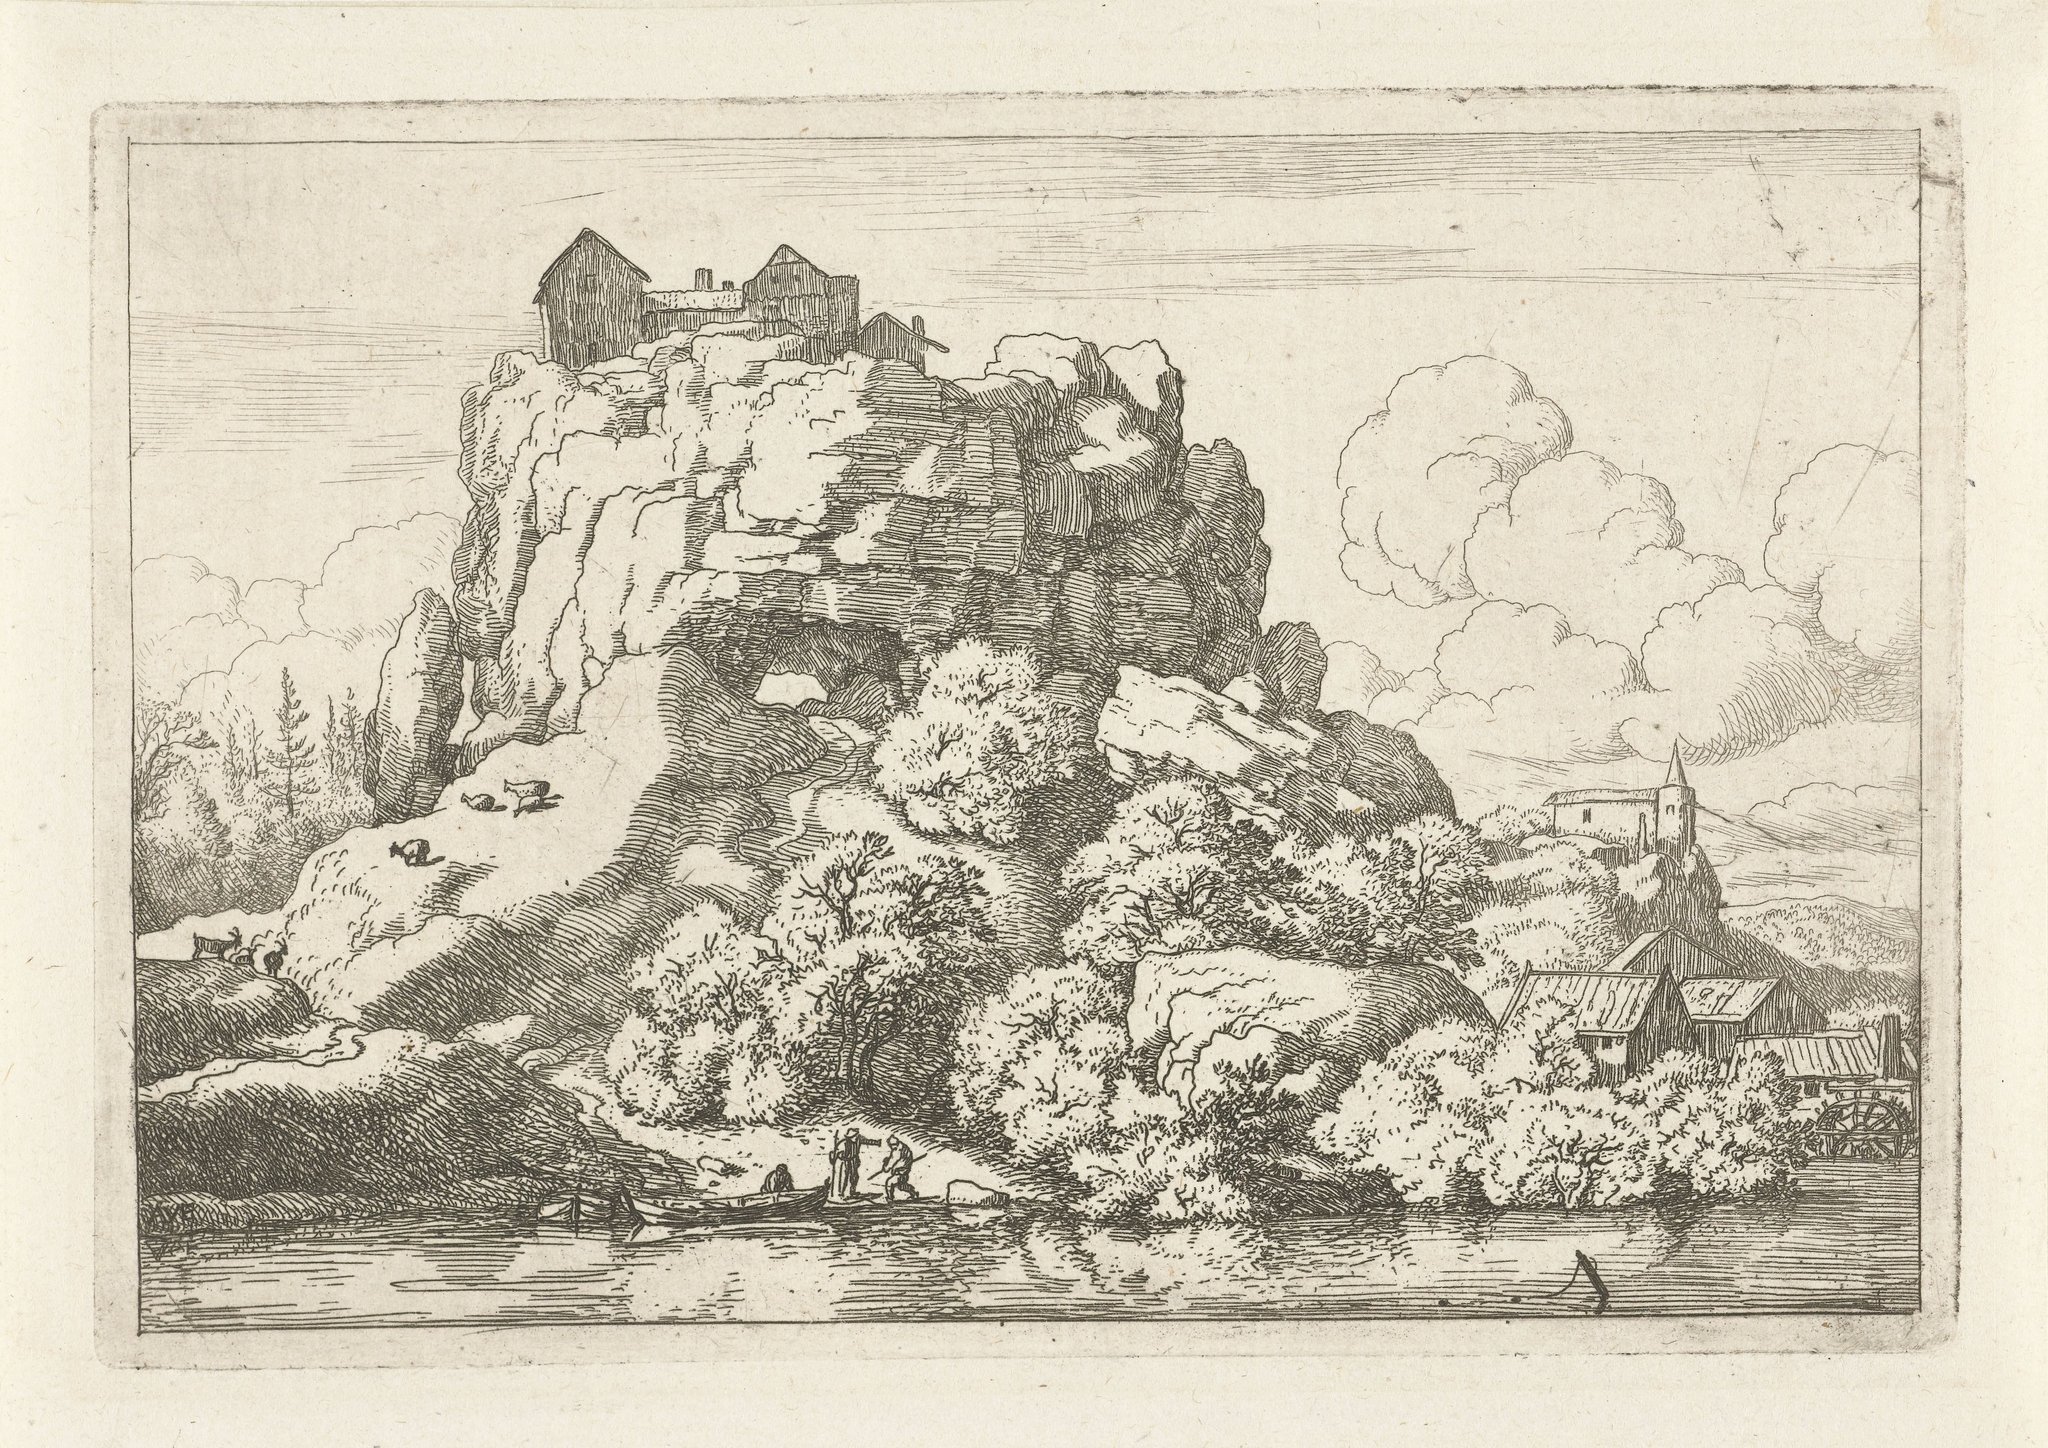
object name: print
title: Landschap met rivier aan de voet van een hoge rots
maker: allaert van everdingen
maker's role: draughtsman, painter, print maker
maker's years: 1621-1675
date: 1631-1675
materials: paper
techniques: etching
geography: netherlands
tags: rock-formations (+ landscape with figures, staffage)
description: Gezicht op een hoge rots met enkele huizen. Onderaan de rots, aan de oever van de rivier, zijn drie personen in de weer bij twee roeiboten.